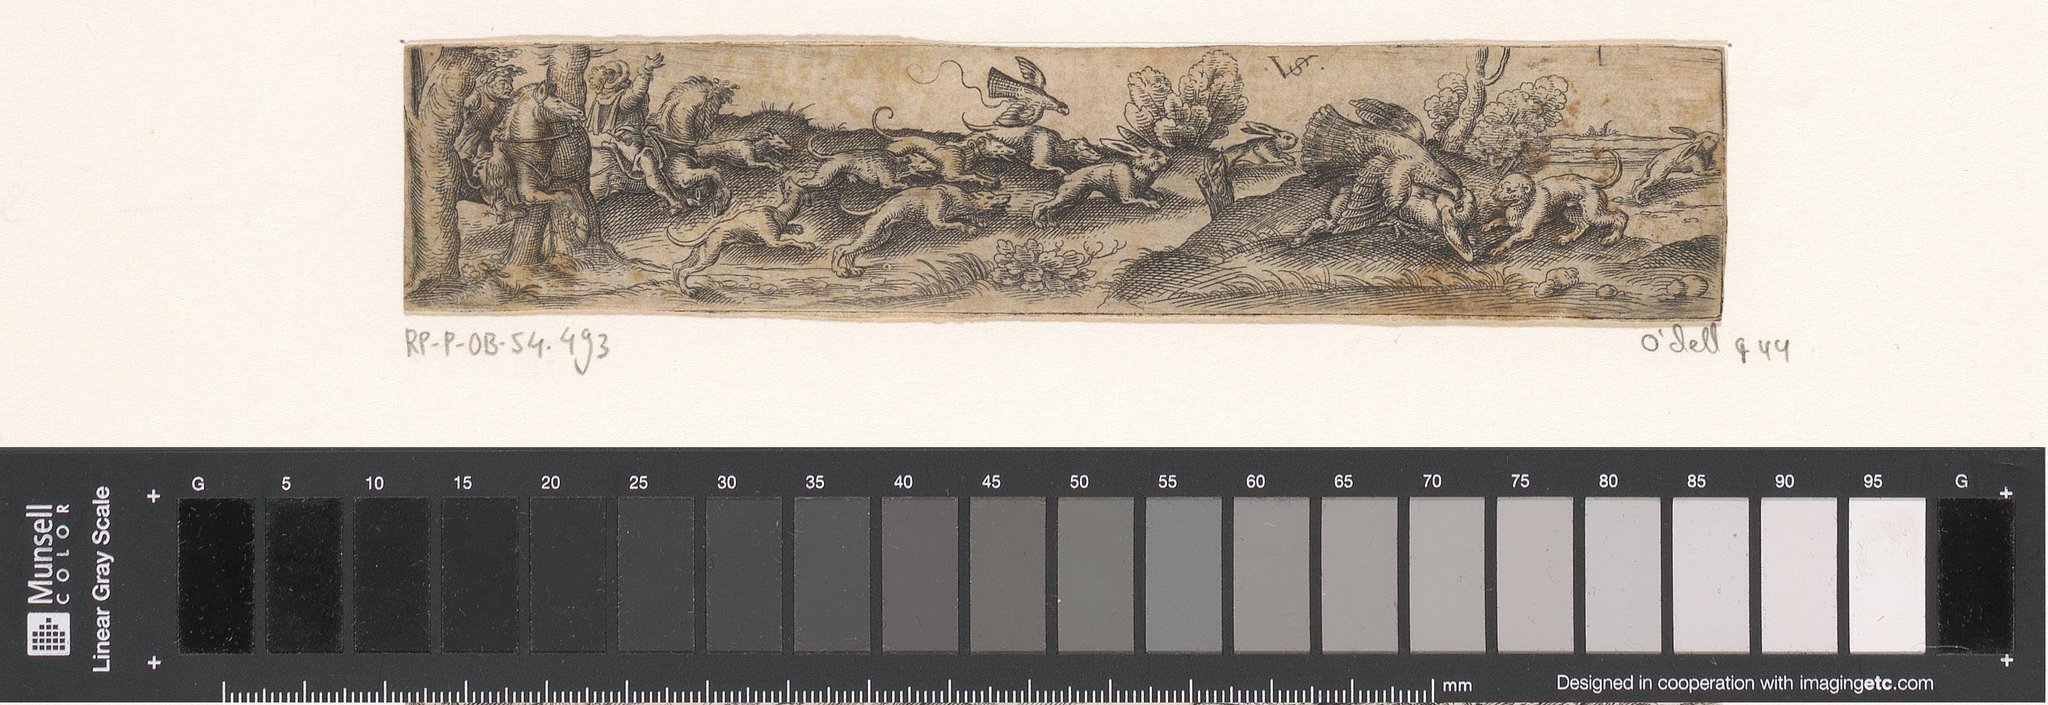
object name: print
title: Hazenjacht met valken en honden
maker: virgilius solis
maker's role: draughtsman, print maker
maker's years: 1514-1562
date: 1524-1562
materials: paper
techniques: engraving, etching, intaglio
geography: nuremberg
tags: predatory birds: falcon, hunting dogs, hare-hunting, rabbit-hunting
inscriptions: number: ‘28’, collector's mark: Lugt 2228